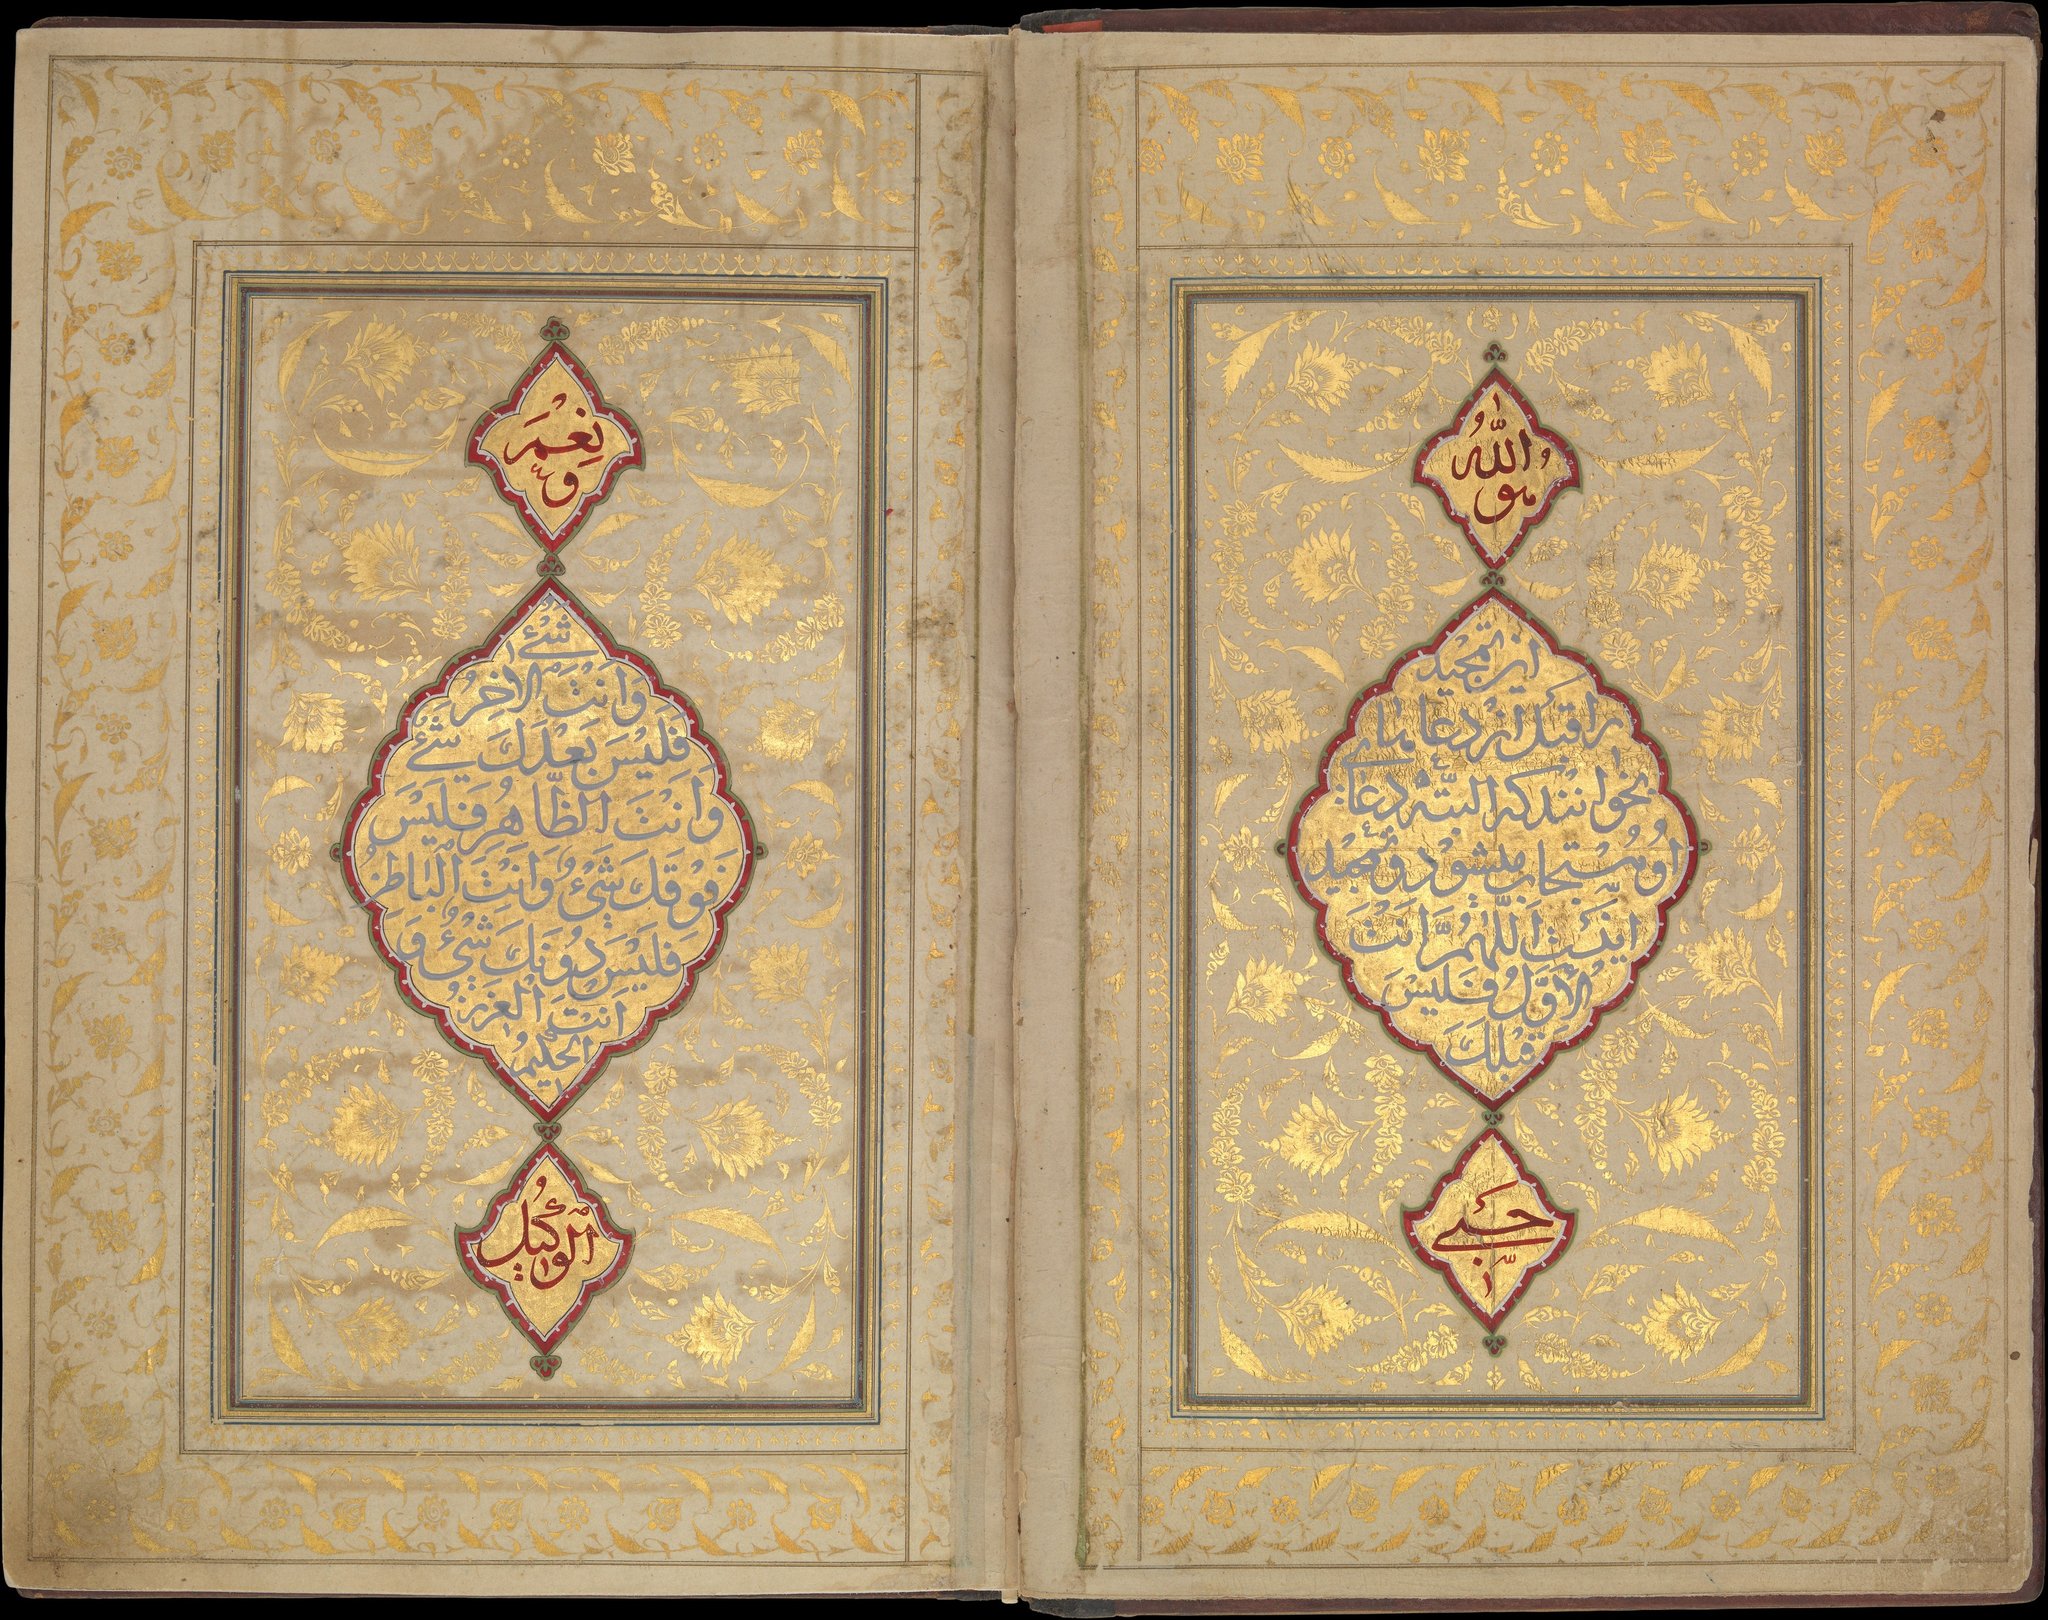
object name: non illustrated manuscript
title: Book of Prayers, Surat al-Yasin and Surat al-Fath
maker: ahmad nairizi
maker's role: calligrapher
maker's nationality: iranian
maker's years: 1657-1764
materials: gold, ink, lacquer, paper, watercolor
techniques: bookbinding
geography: iran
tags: arabic,calligraphy